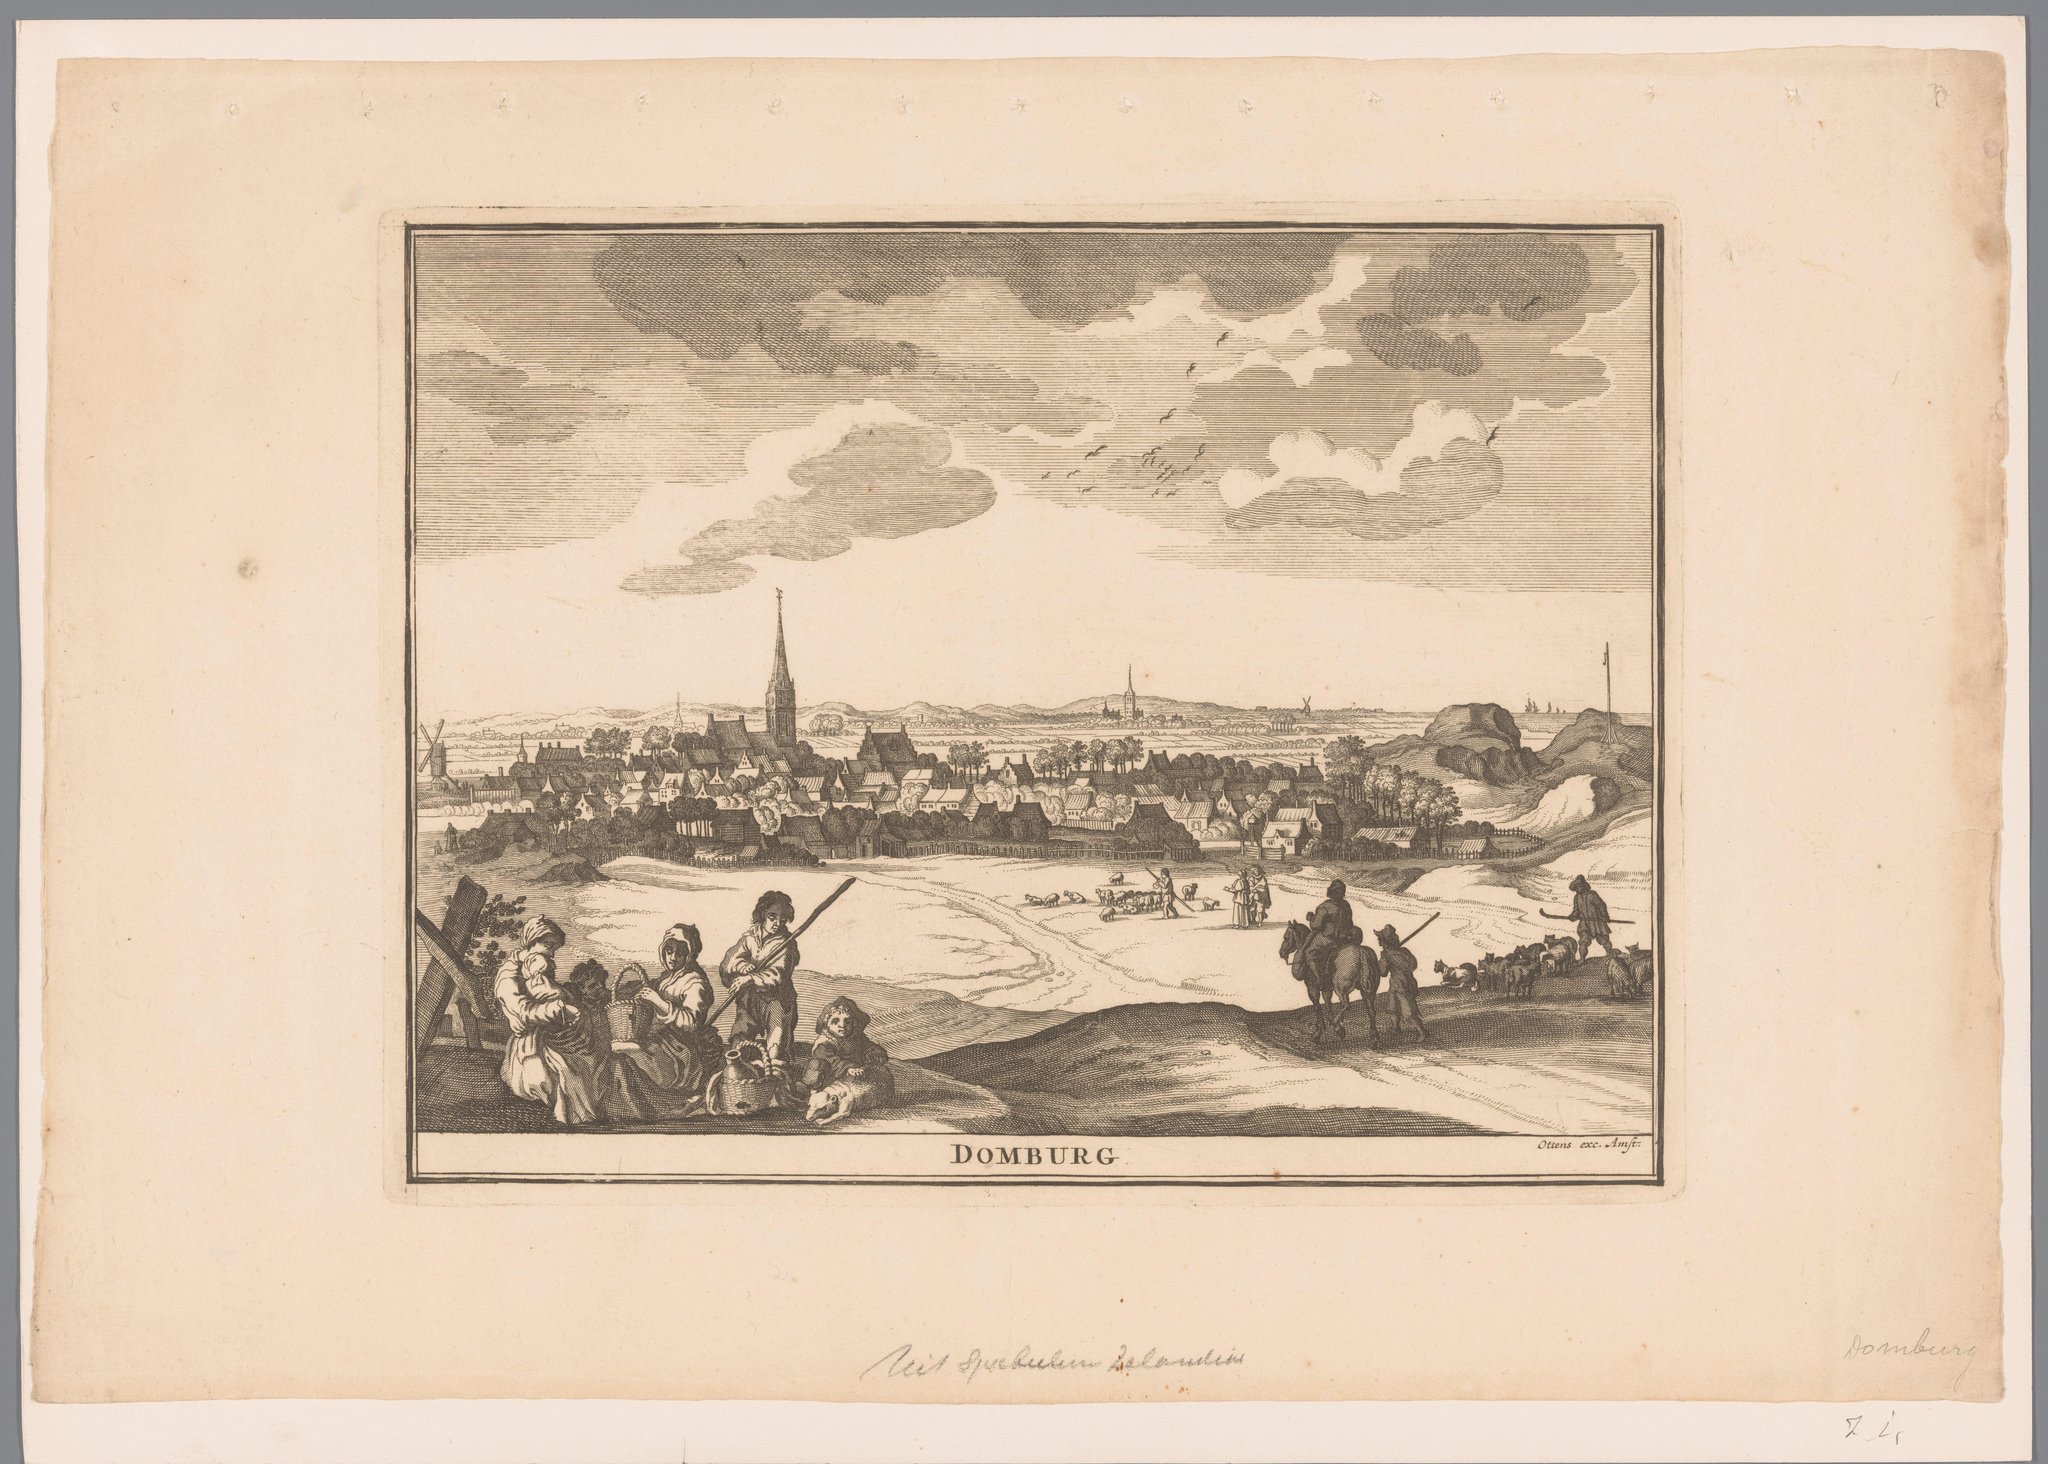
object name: print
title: Domburg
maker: pieter hendricksz. schut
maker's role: print maker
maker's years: 1618-1660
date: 1719-1725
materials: paper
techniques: etching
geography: amsterdam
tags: prospect of village, silhouette of village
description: Prent uit: Speculum Zelandiae dat is een beschryvinge ofte afbeelding der steden, ambachts-heerlijckheden, dorpen castelen, ridderlijcke hofsteden, huysen en gebouwen gelegen inde eylanden en de graeflijckheyt van Zeelandt. Amsterdam: weduwe Ottens en Zoonen, [1719-1725]. Eerdere staat/staten van prenten is/zijn gebruikt in eerdere uitgaven van 'Speculum Zelandiae' en in andere publicaties uitgegeven door Zacharias Roman en Nicolaes Visscher (I). De eerste publicatie waarin de eerste staat van de prent rechtsonder voorkomt dateert uit 1656. De eerste publicatie waarin de eerste staat van de andere drie prenten voorkomt dateert uit 1657.